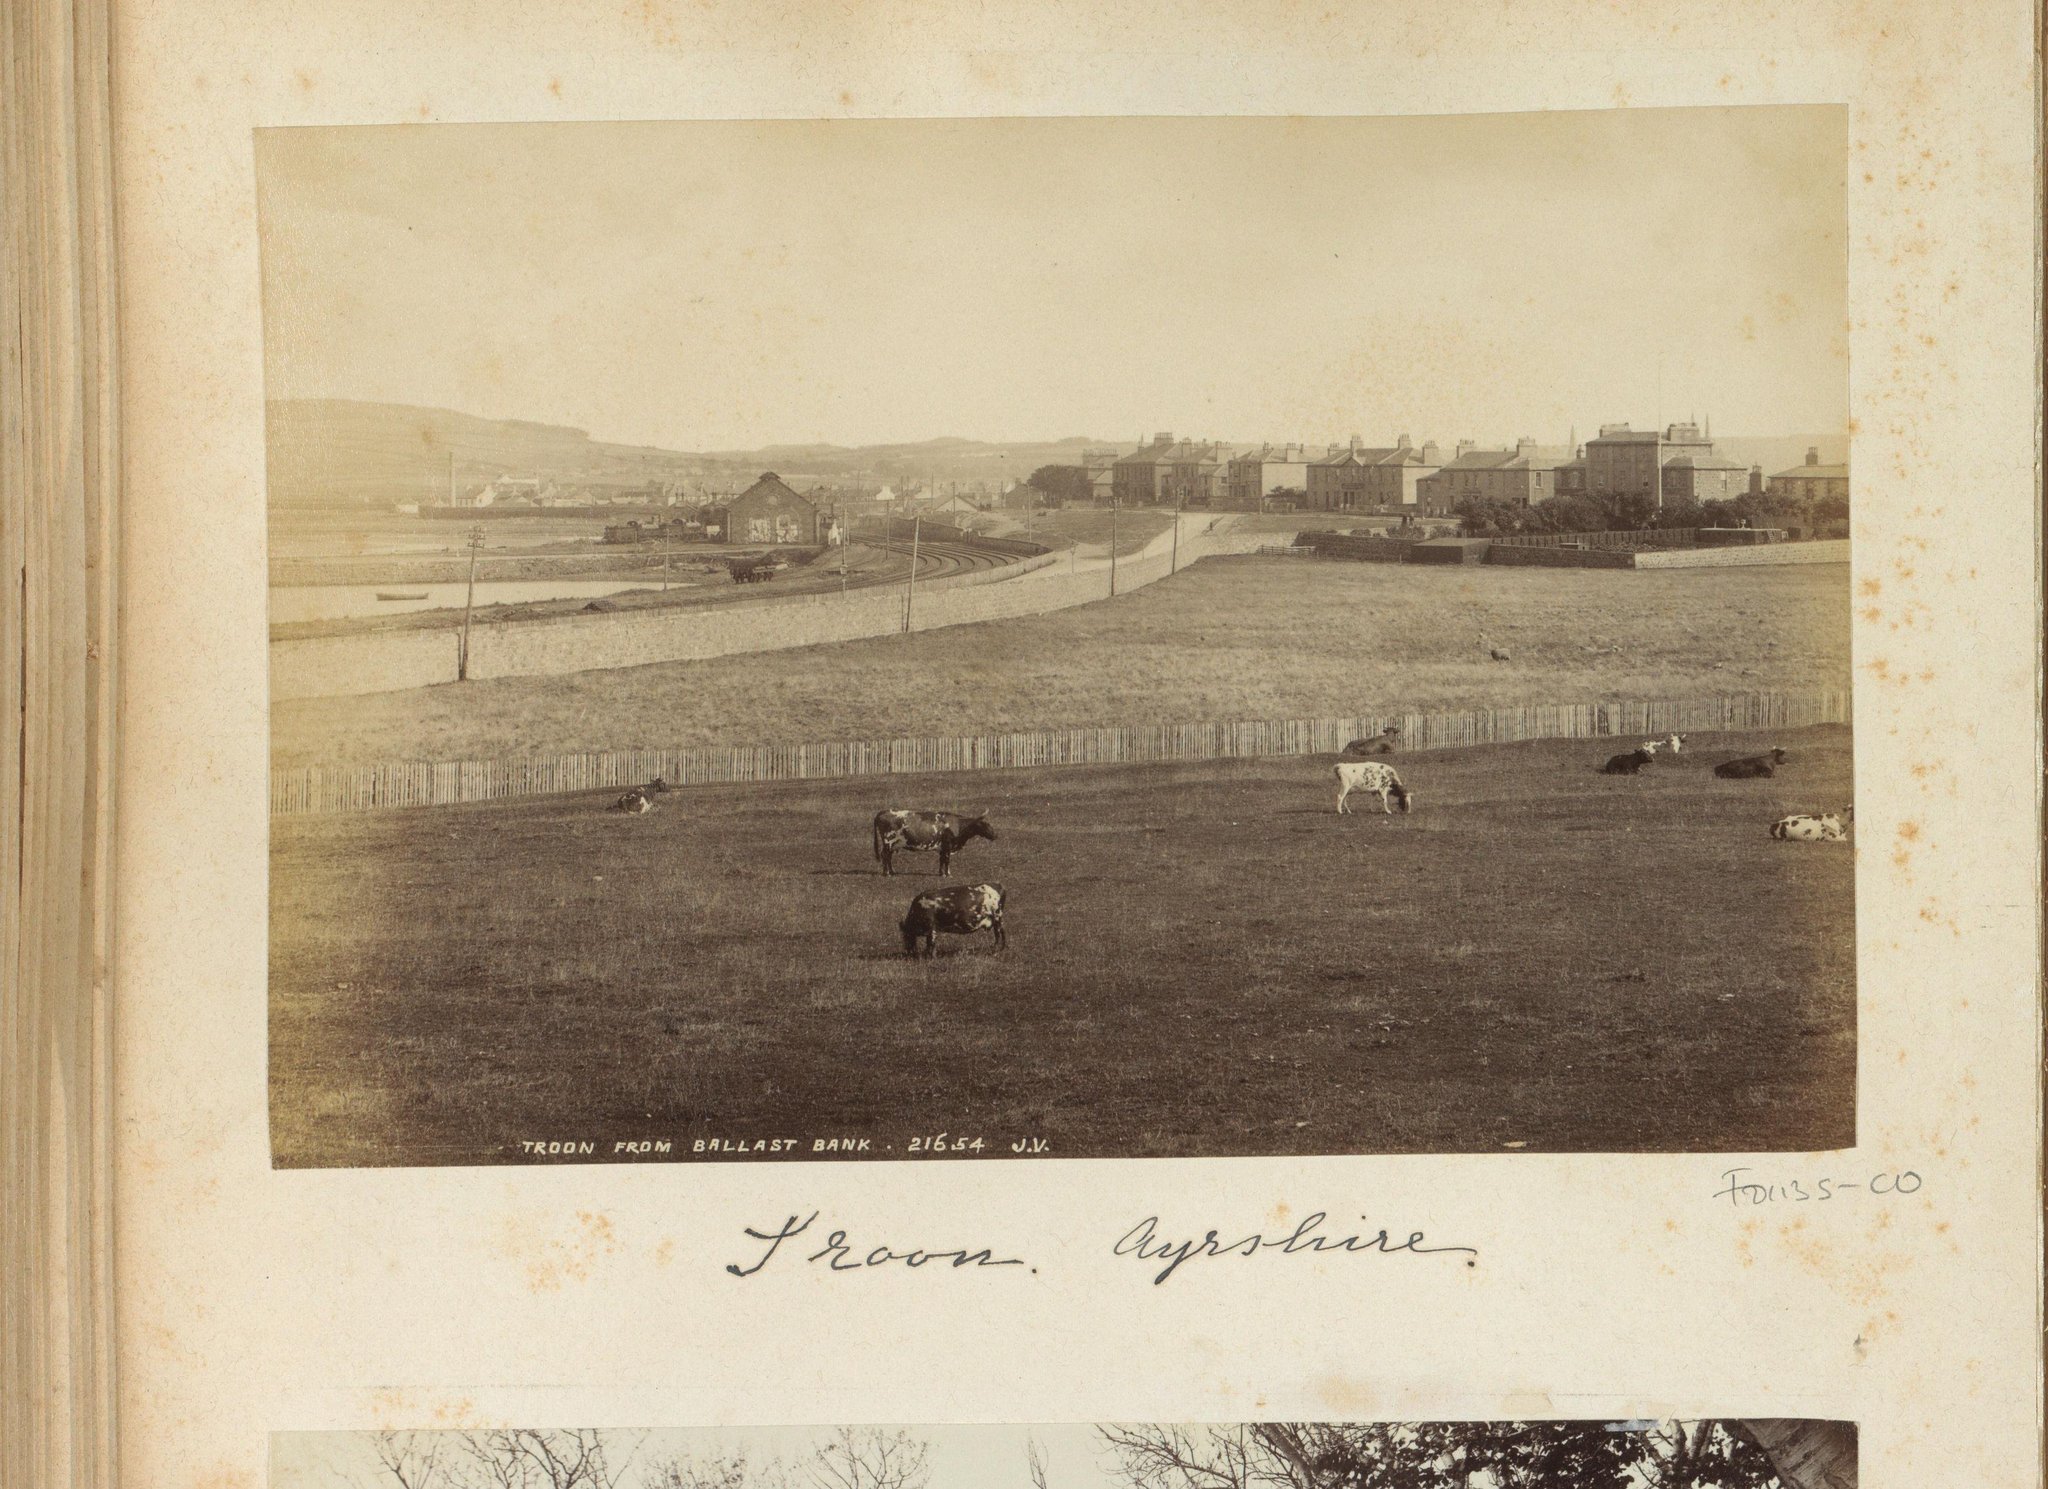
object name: photograph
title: Troon from Ballast Bank.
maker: james valentine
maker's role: fotograaf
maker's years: 1815-1880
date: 1900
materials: paper, photographic support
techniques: albumen print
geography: oostende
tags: prospect of village, silhouette of village, cattle, railway, train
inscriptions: negative number: ‘21654’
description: Onderdeel van Reisalbum met foto's van bezienswaardigheden in Engeland en Frankrijk.